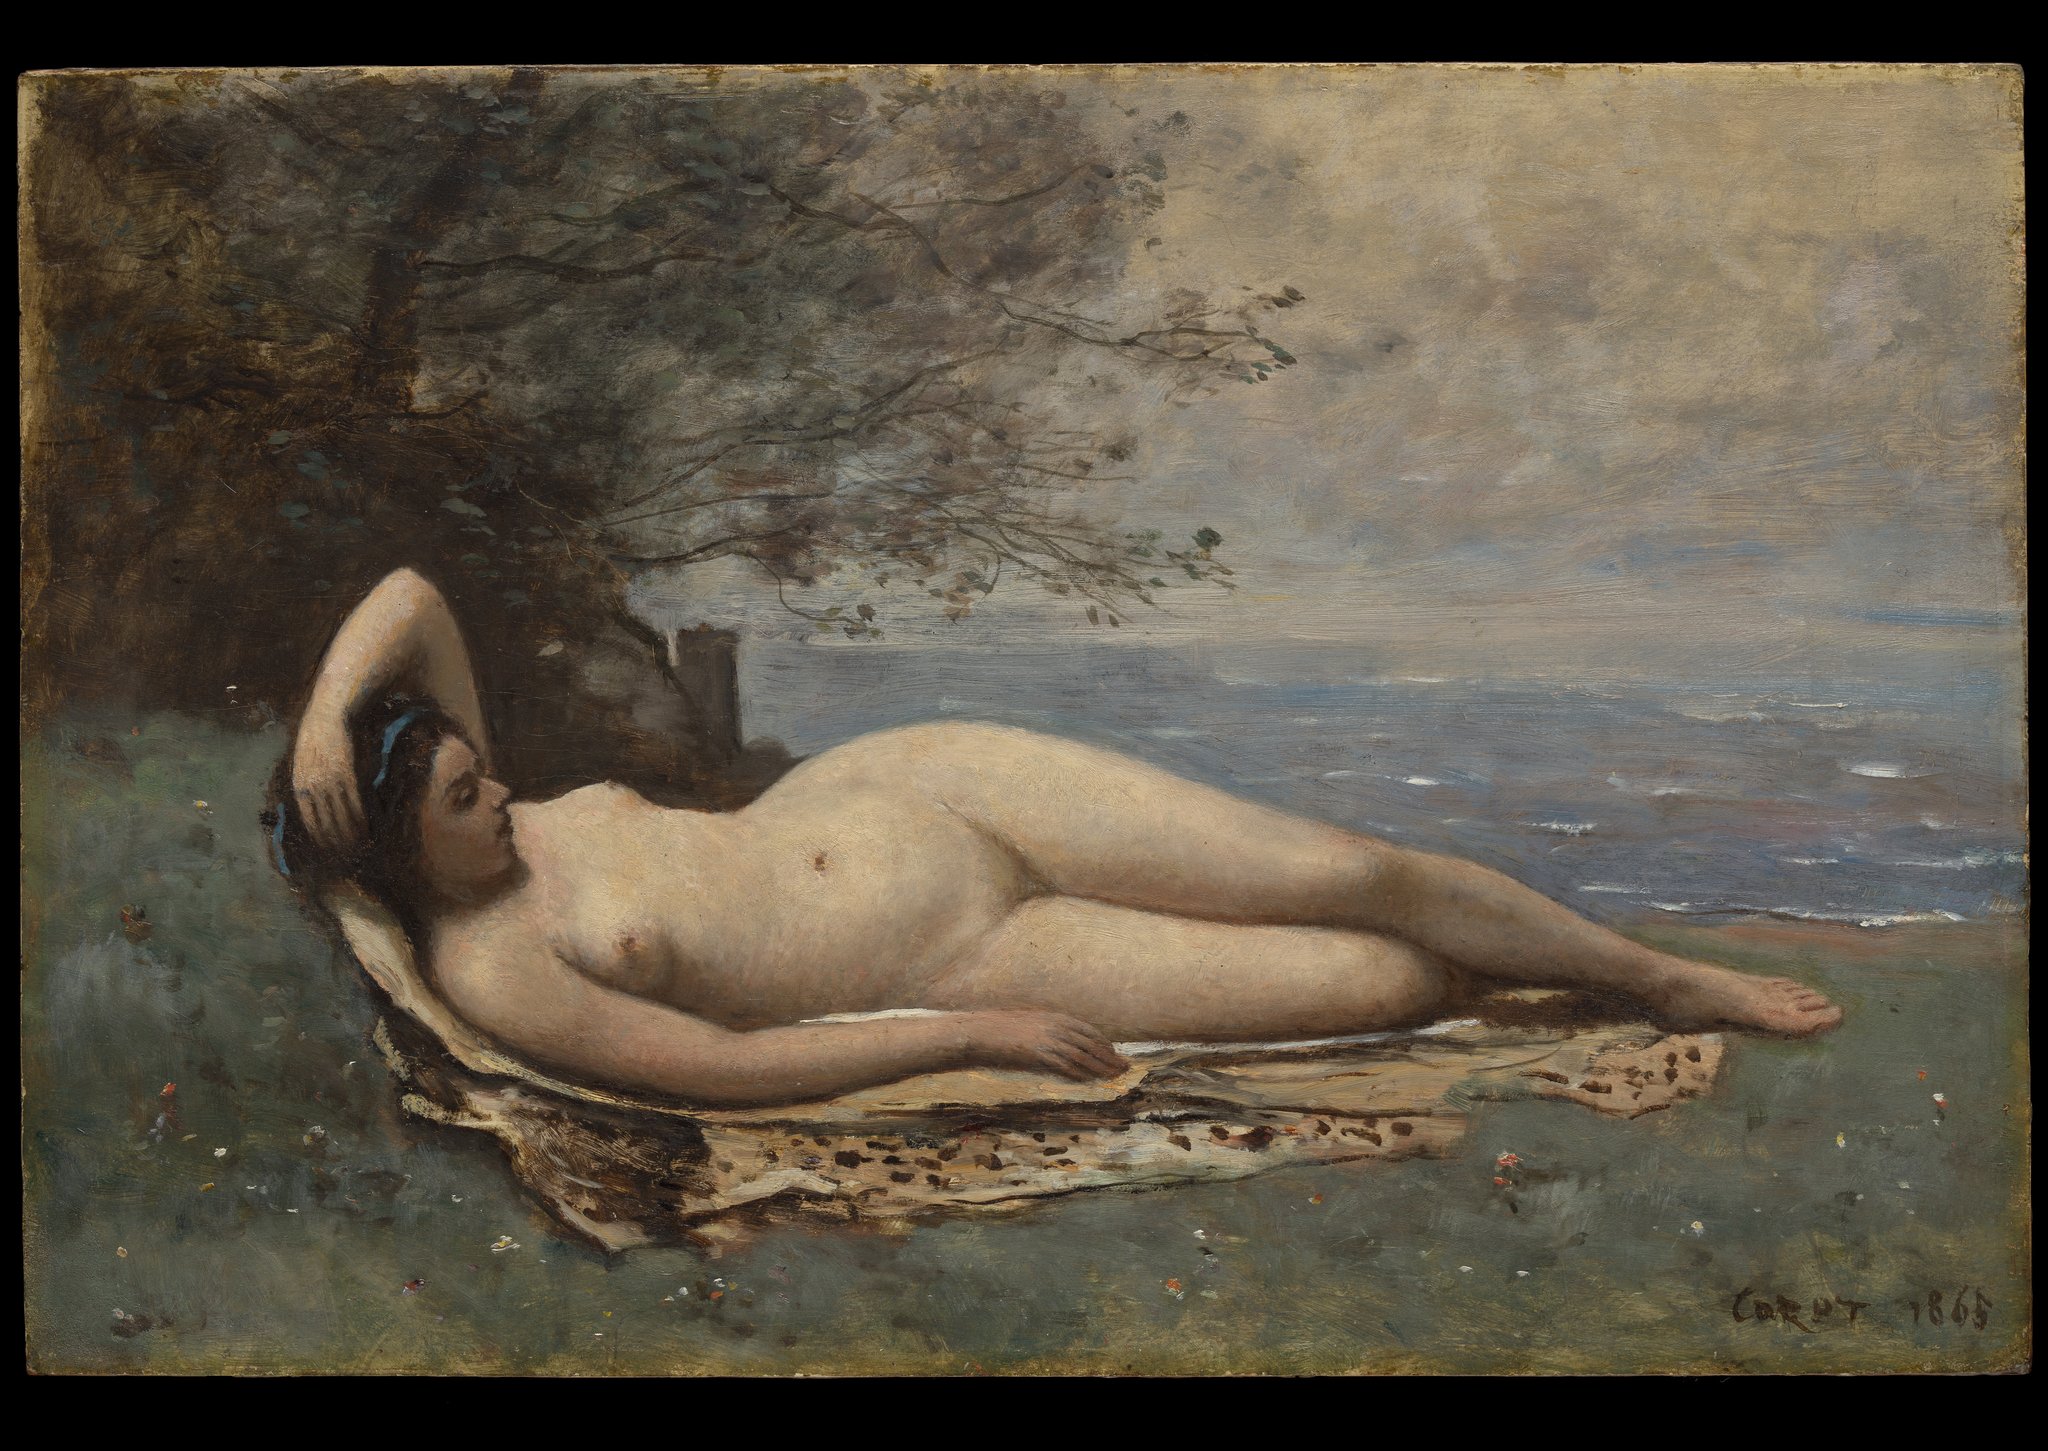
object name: painting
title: Bacchante by the Sea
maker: jean-baptiste-camille corot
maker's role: artist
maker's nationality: french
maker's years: 1796-1875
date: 1865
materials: oil, wood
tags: female nudes,bacchantes